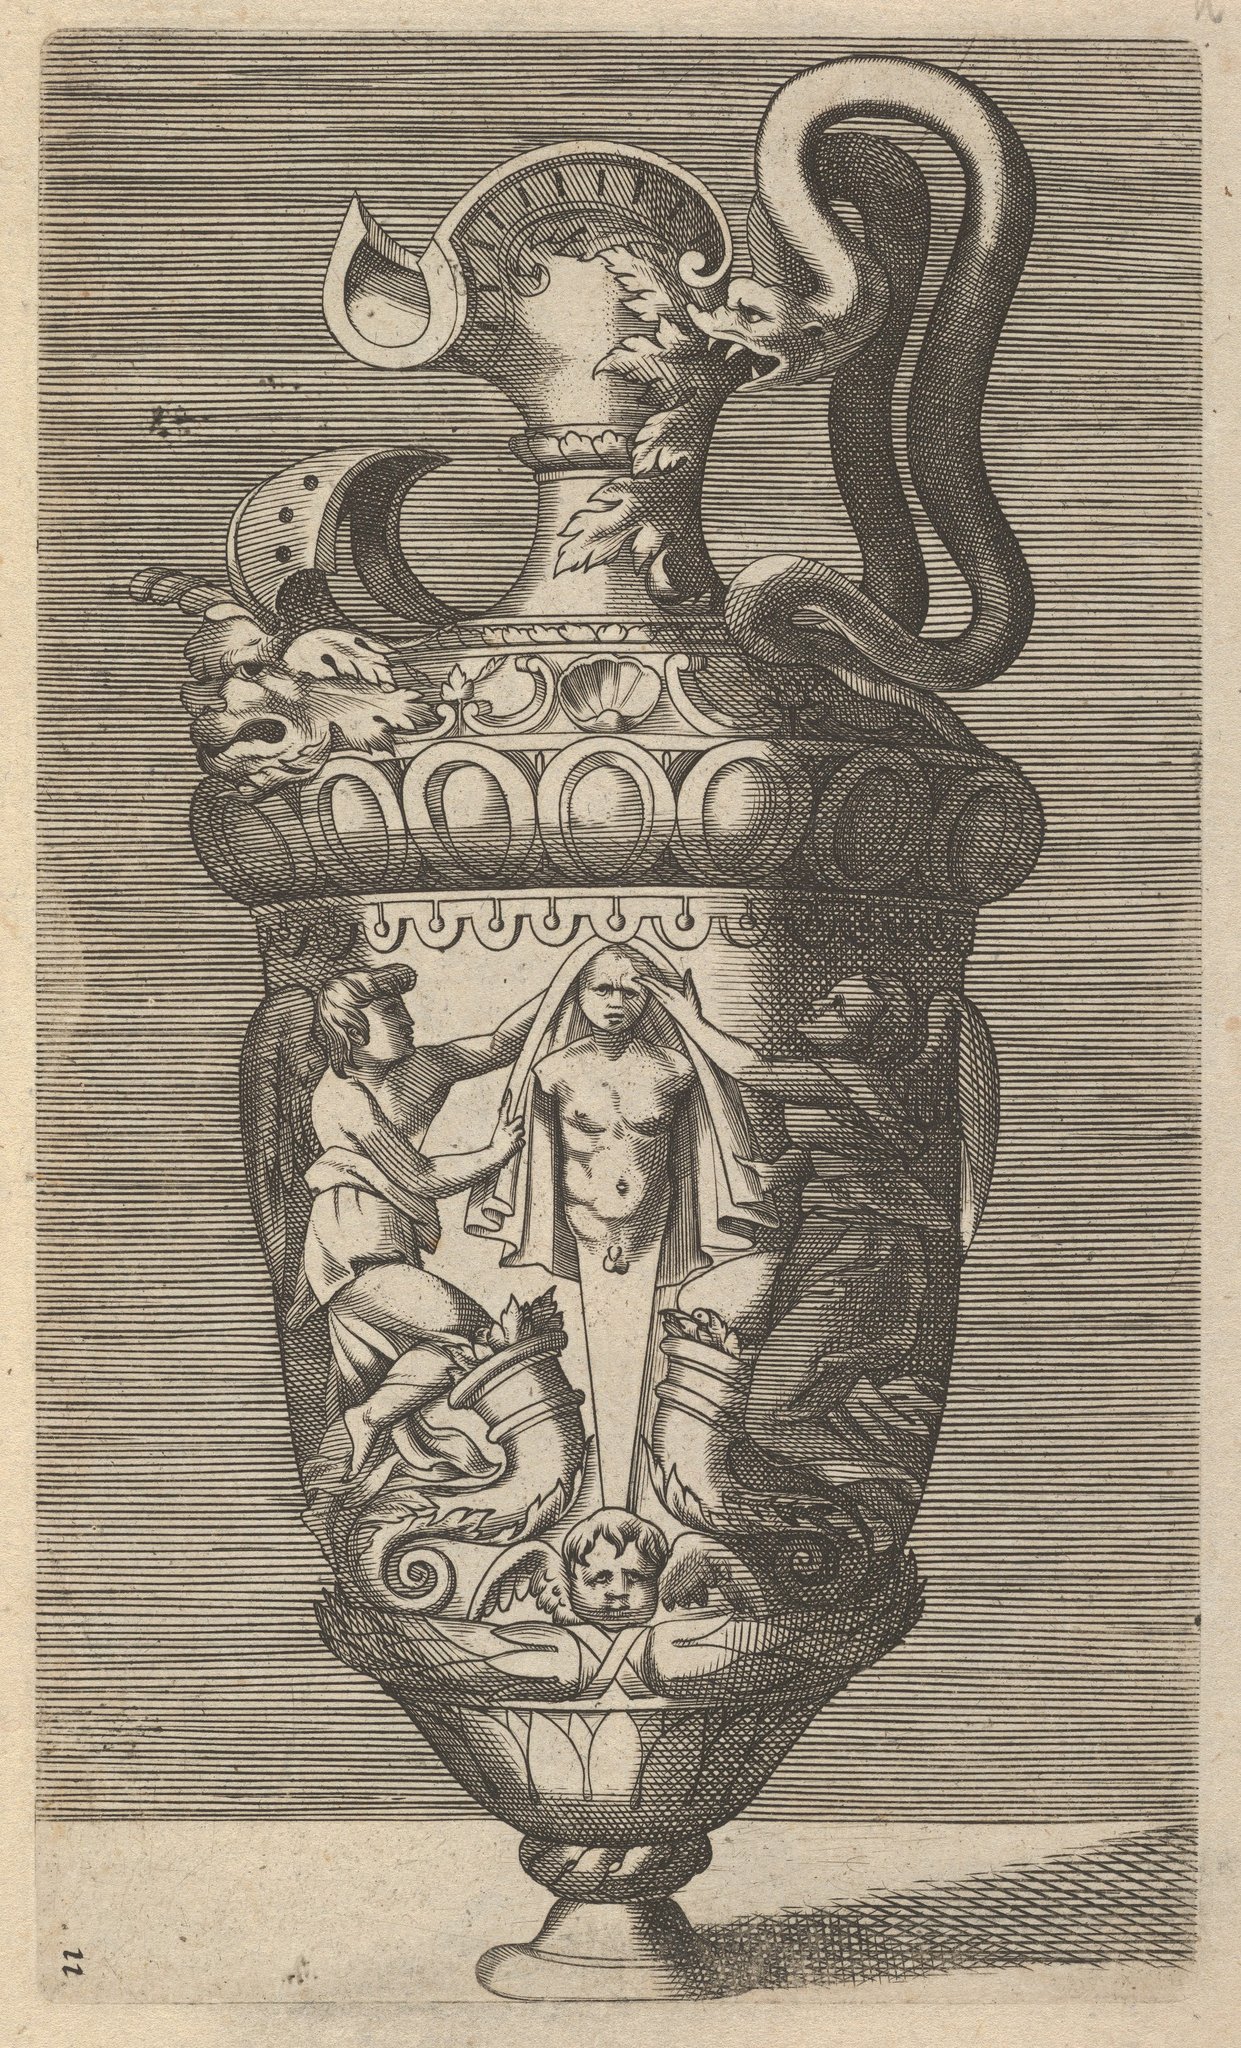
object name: print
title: Vase with Two Winged Figures Draping a Term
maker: rené boyvin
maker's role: artist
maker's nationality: french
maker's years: 1525-1598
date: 1601-1700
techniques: engraving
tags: vases